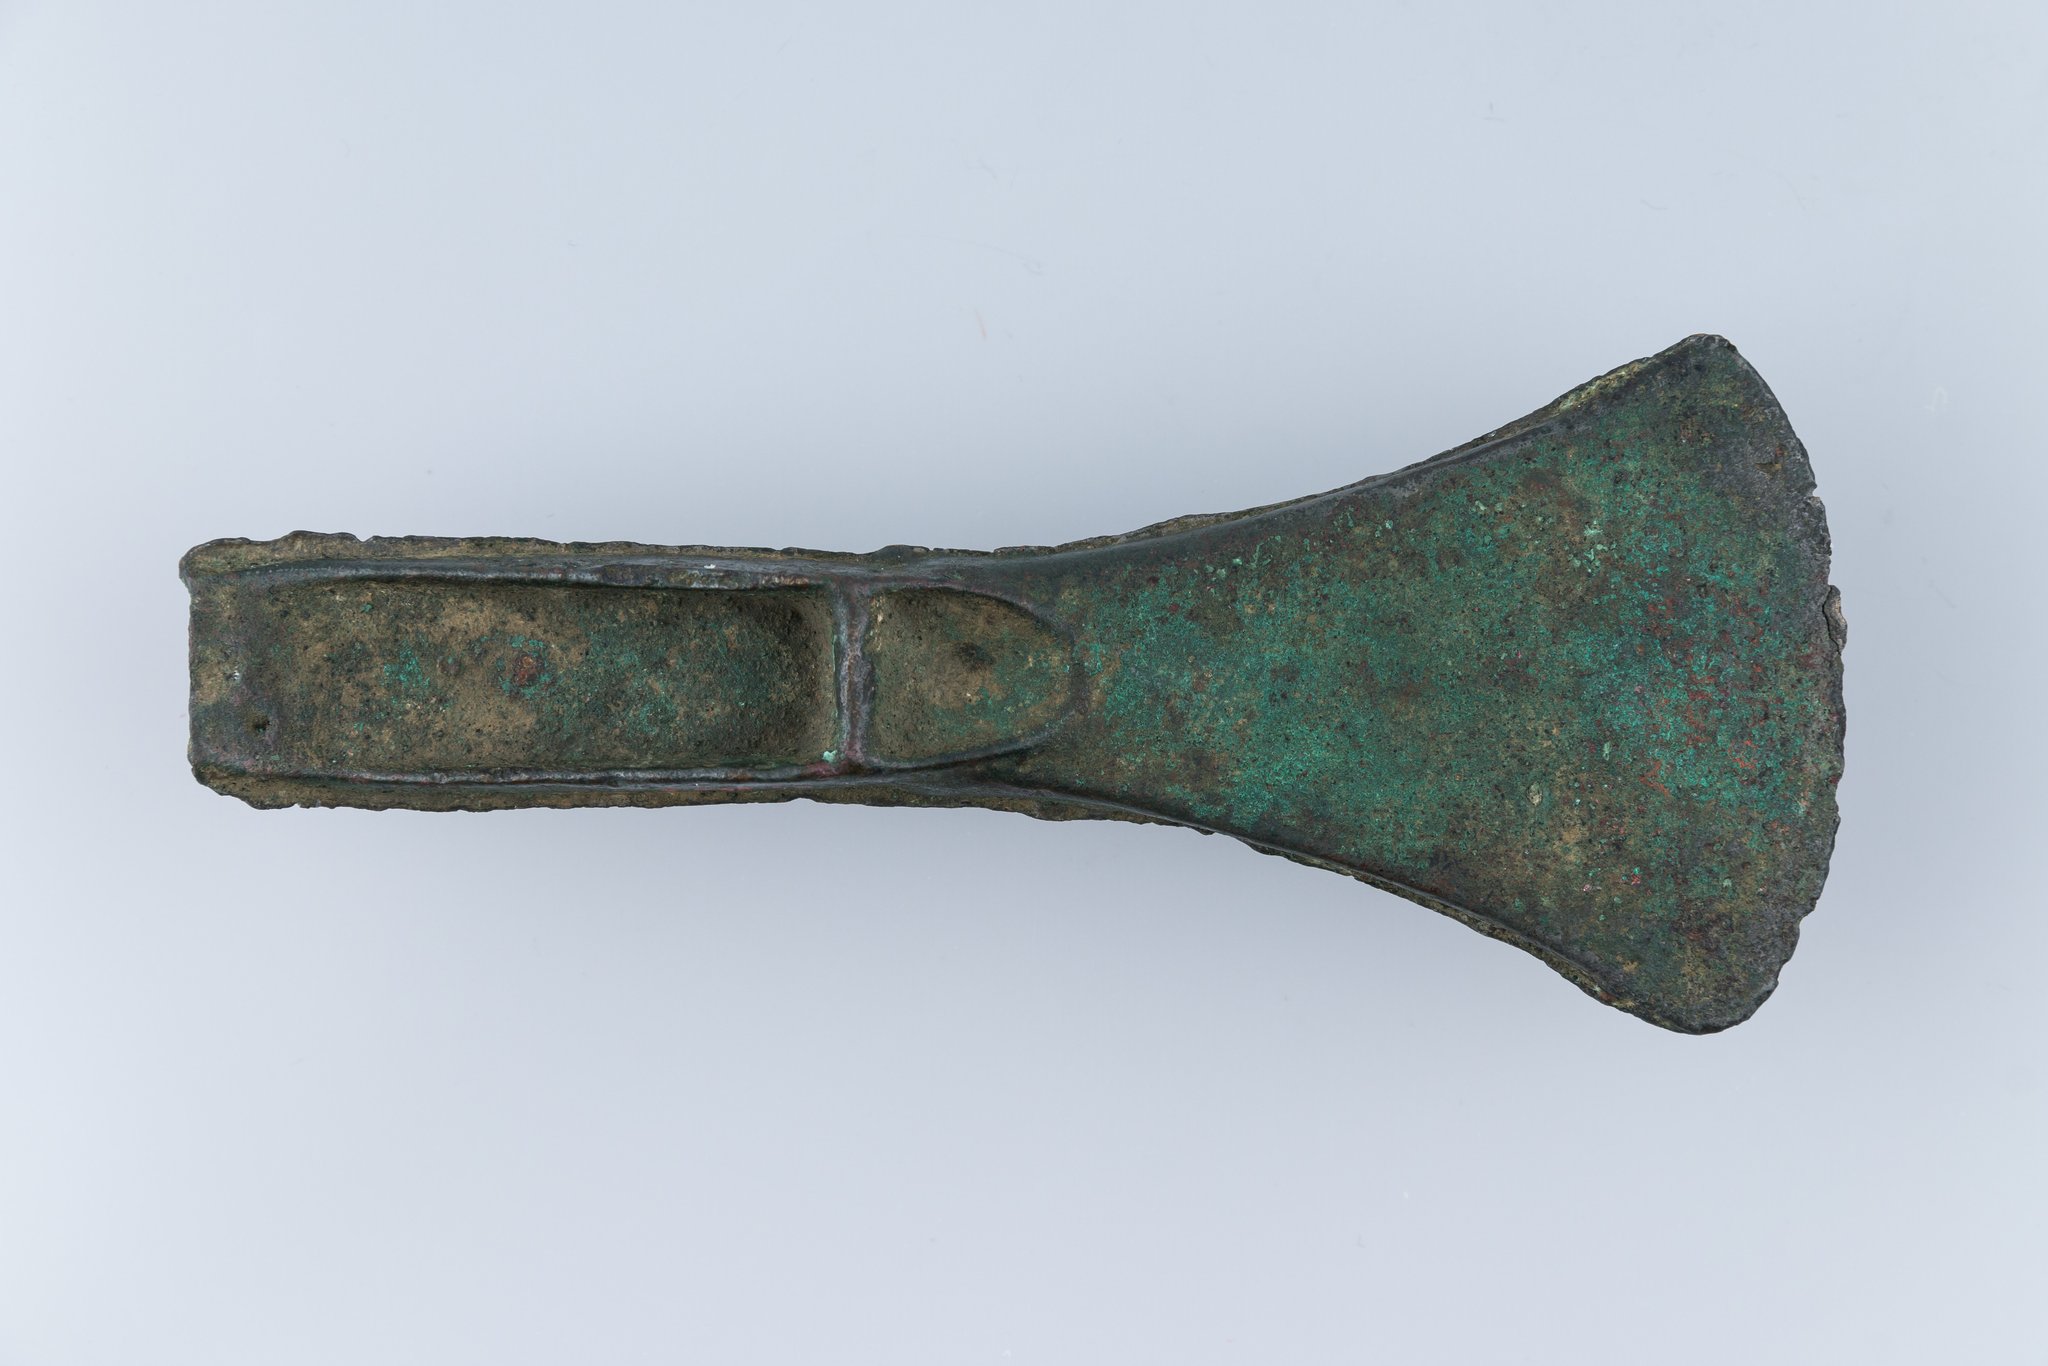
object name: ax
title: Ax of the Palstave Type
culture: irish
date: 1400-1200 BCE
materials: bronze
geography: ireland